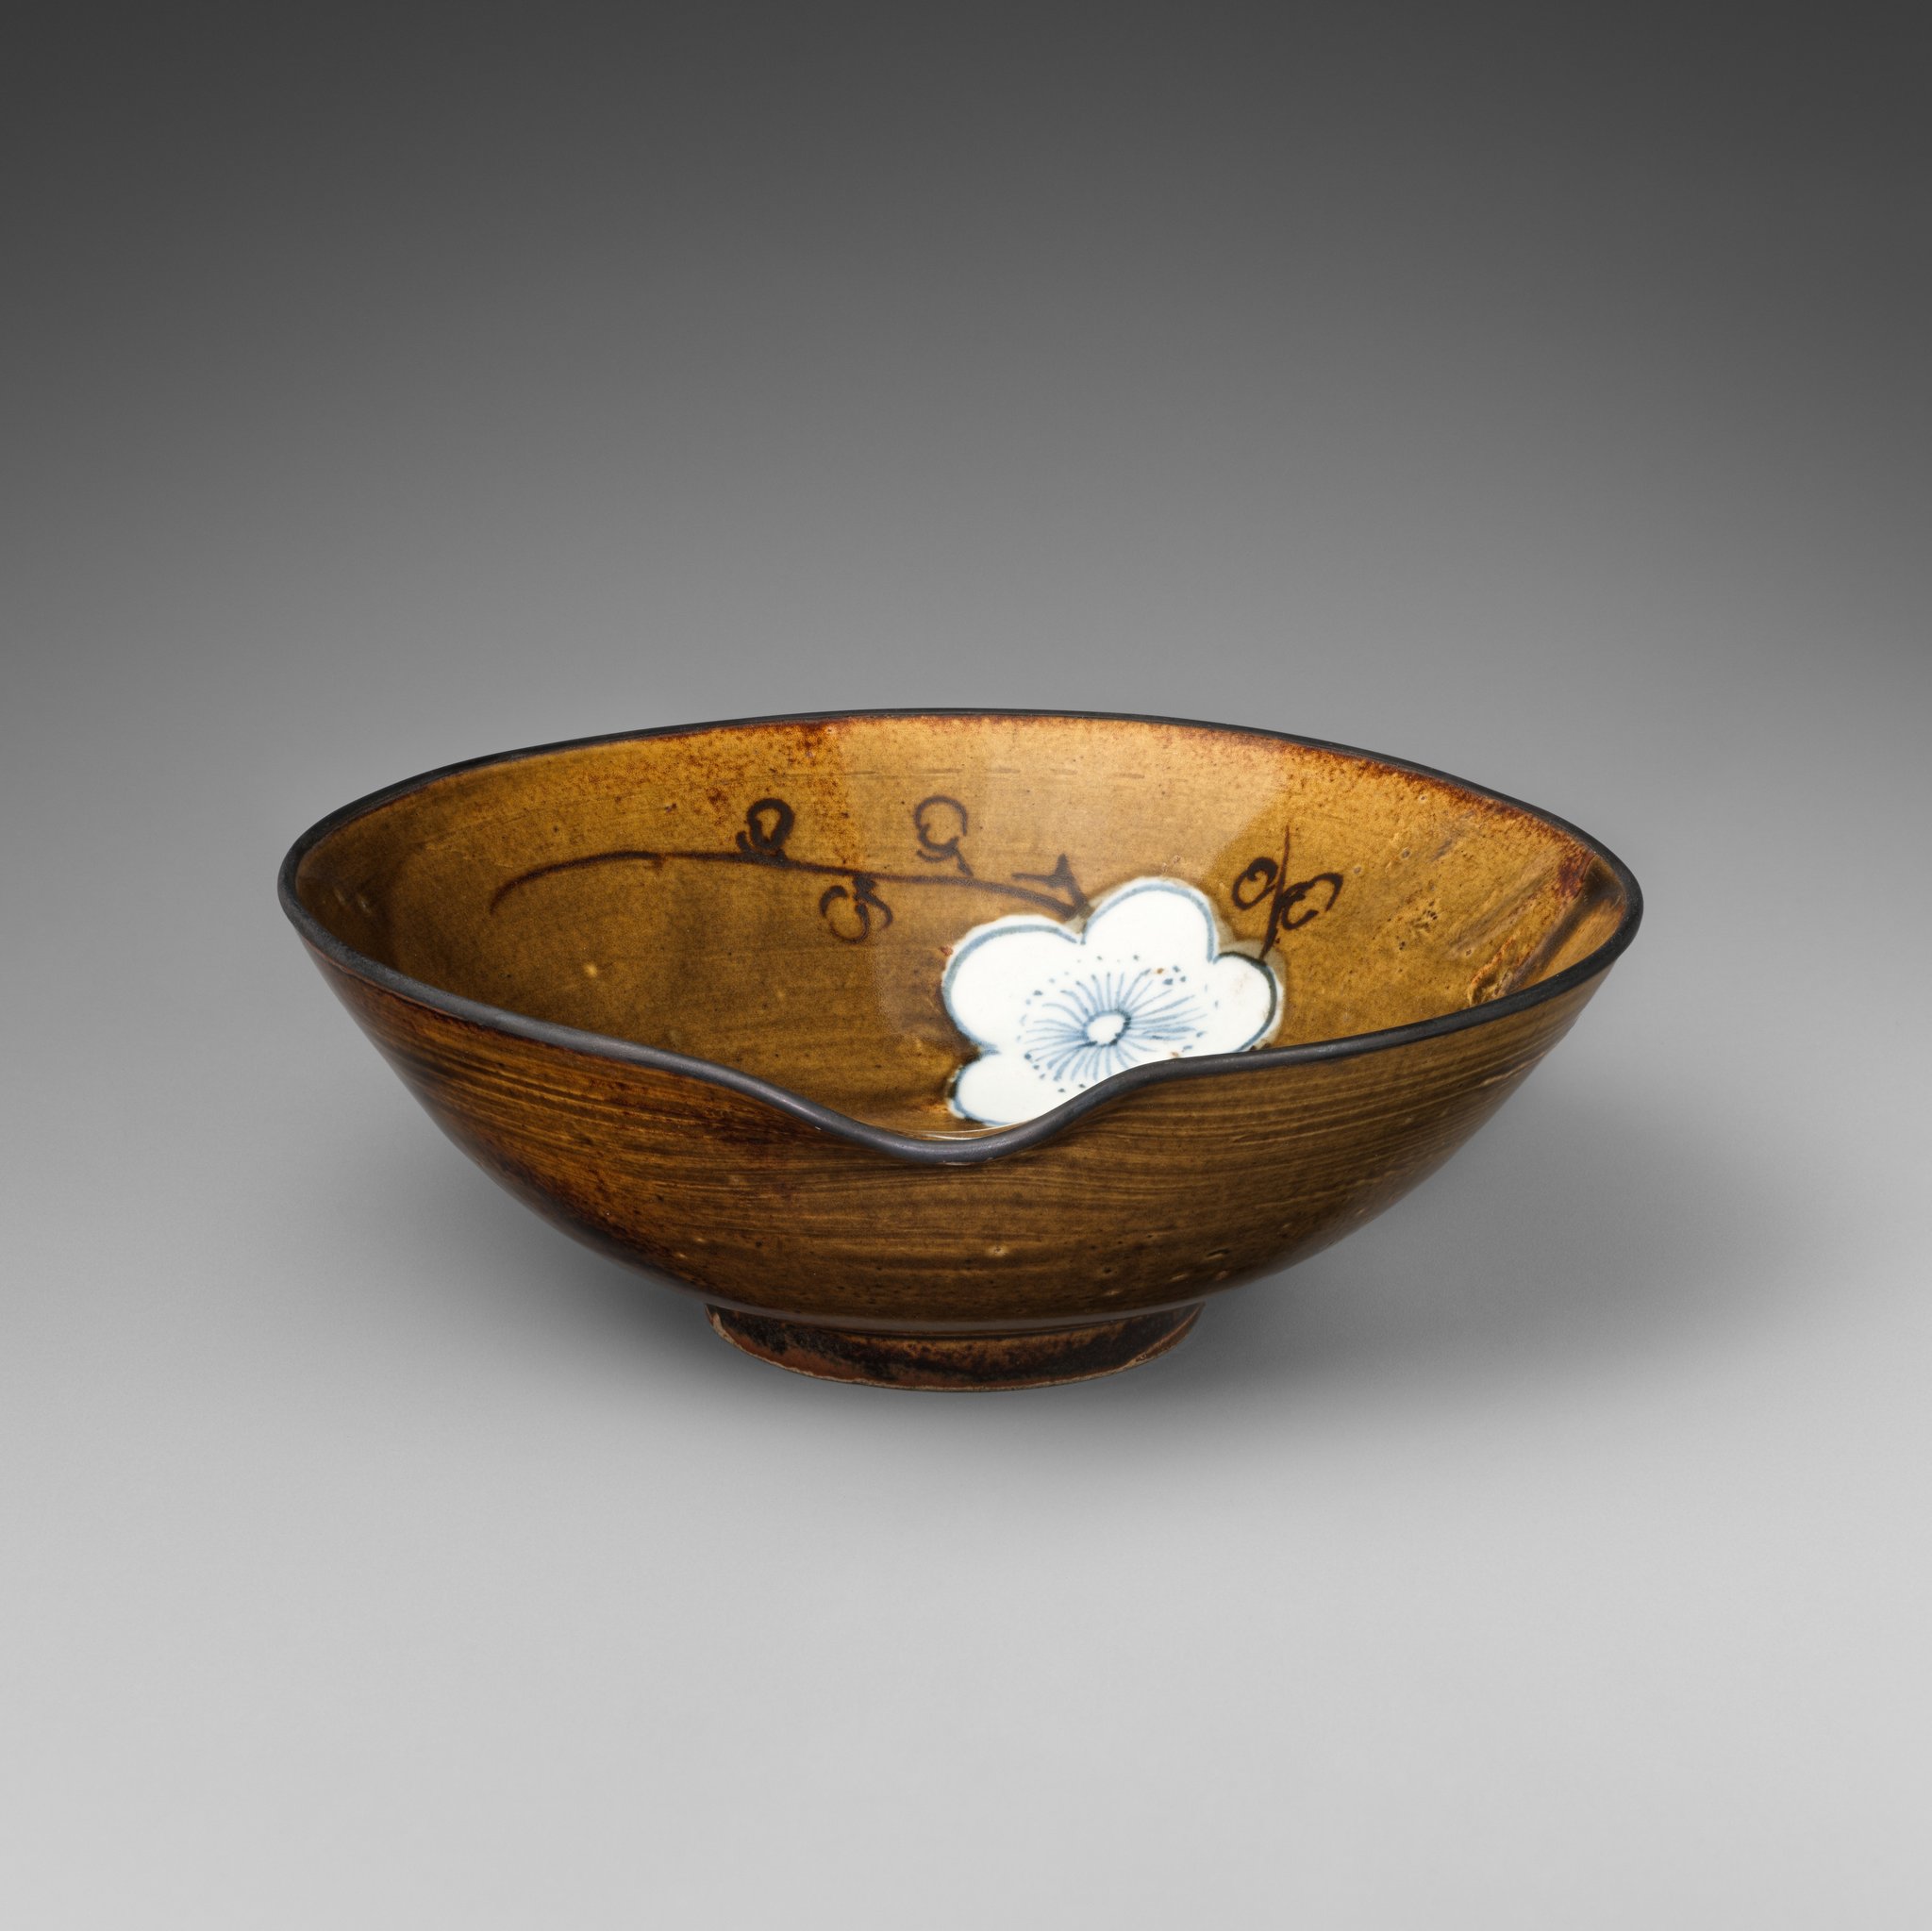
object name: bowl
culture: japanese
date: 1701-1800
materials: cobalt, glaze, iron, porcelain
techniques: underglaze